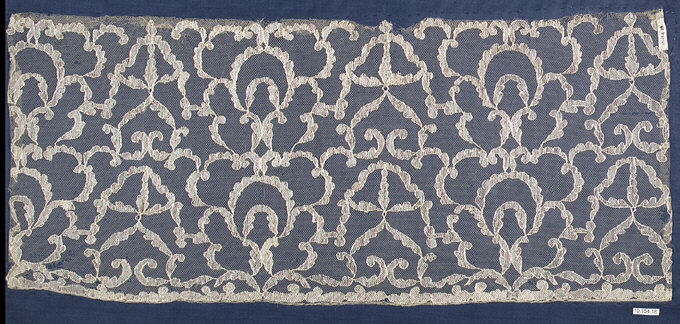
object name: flounce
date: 1801-1900